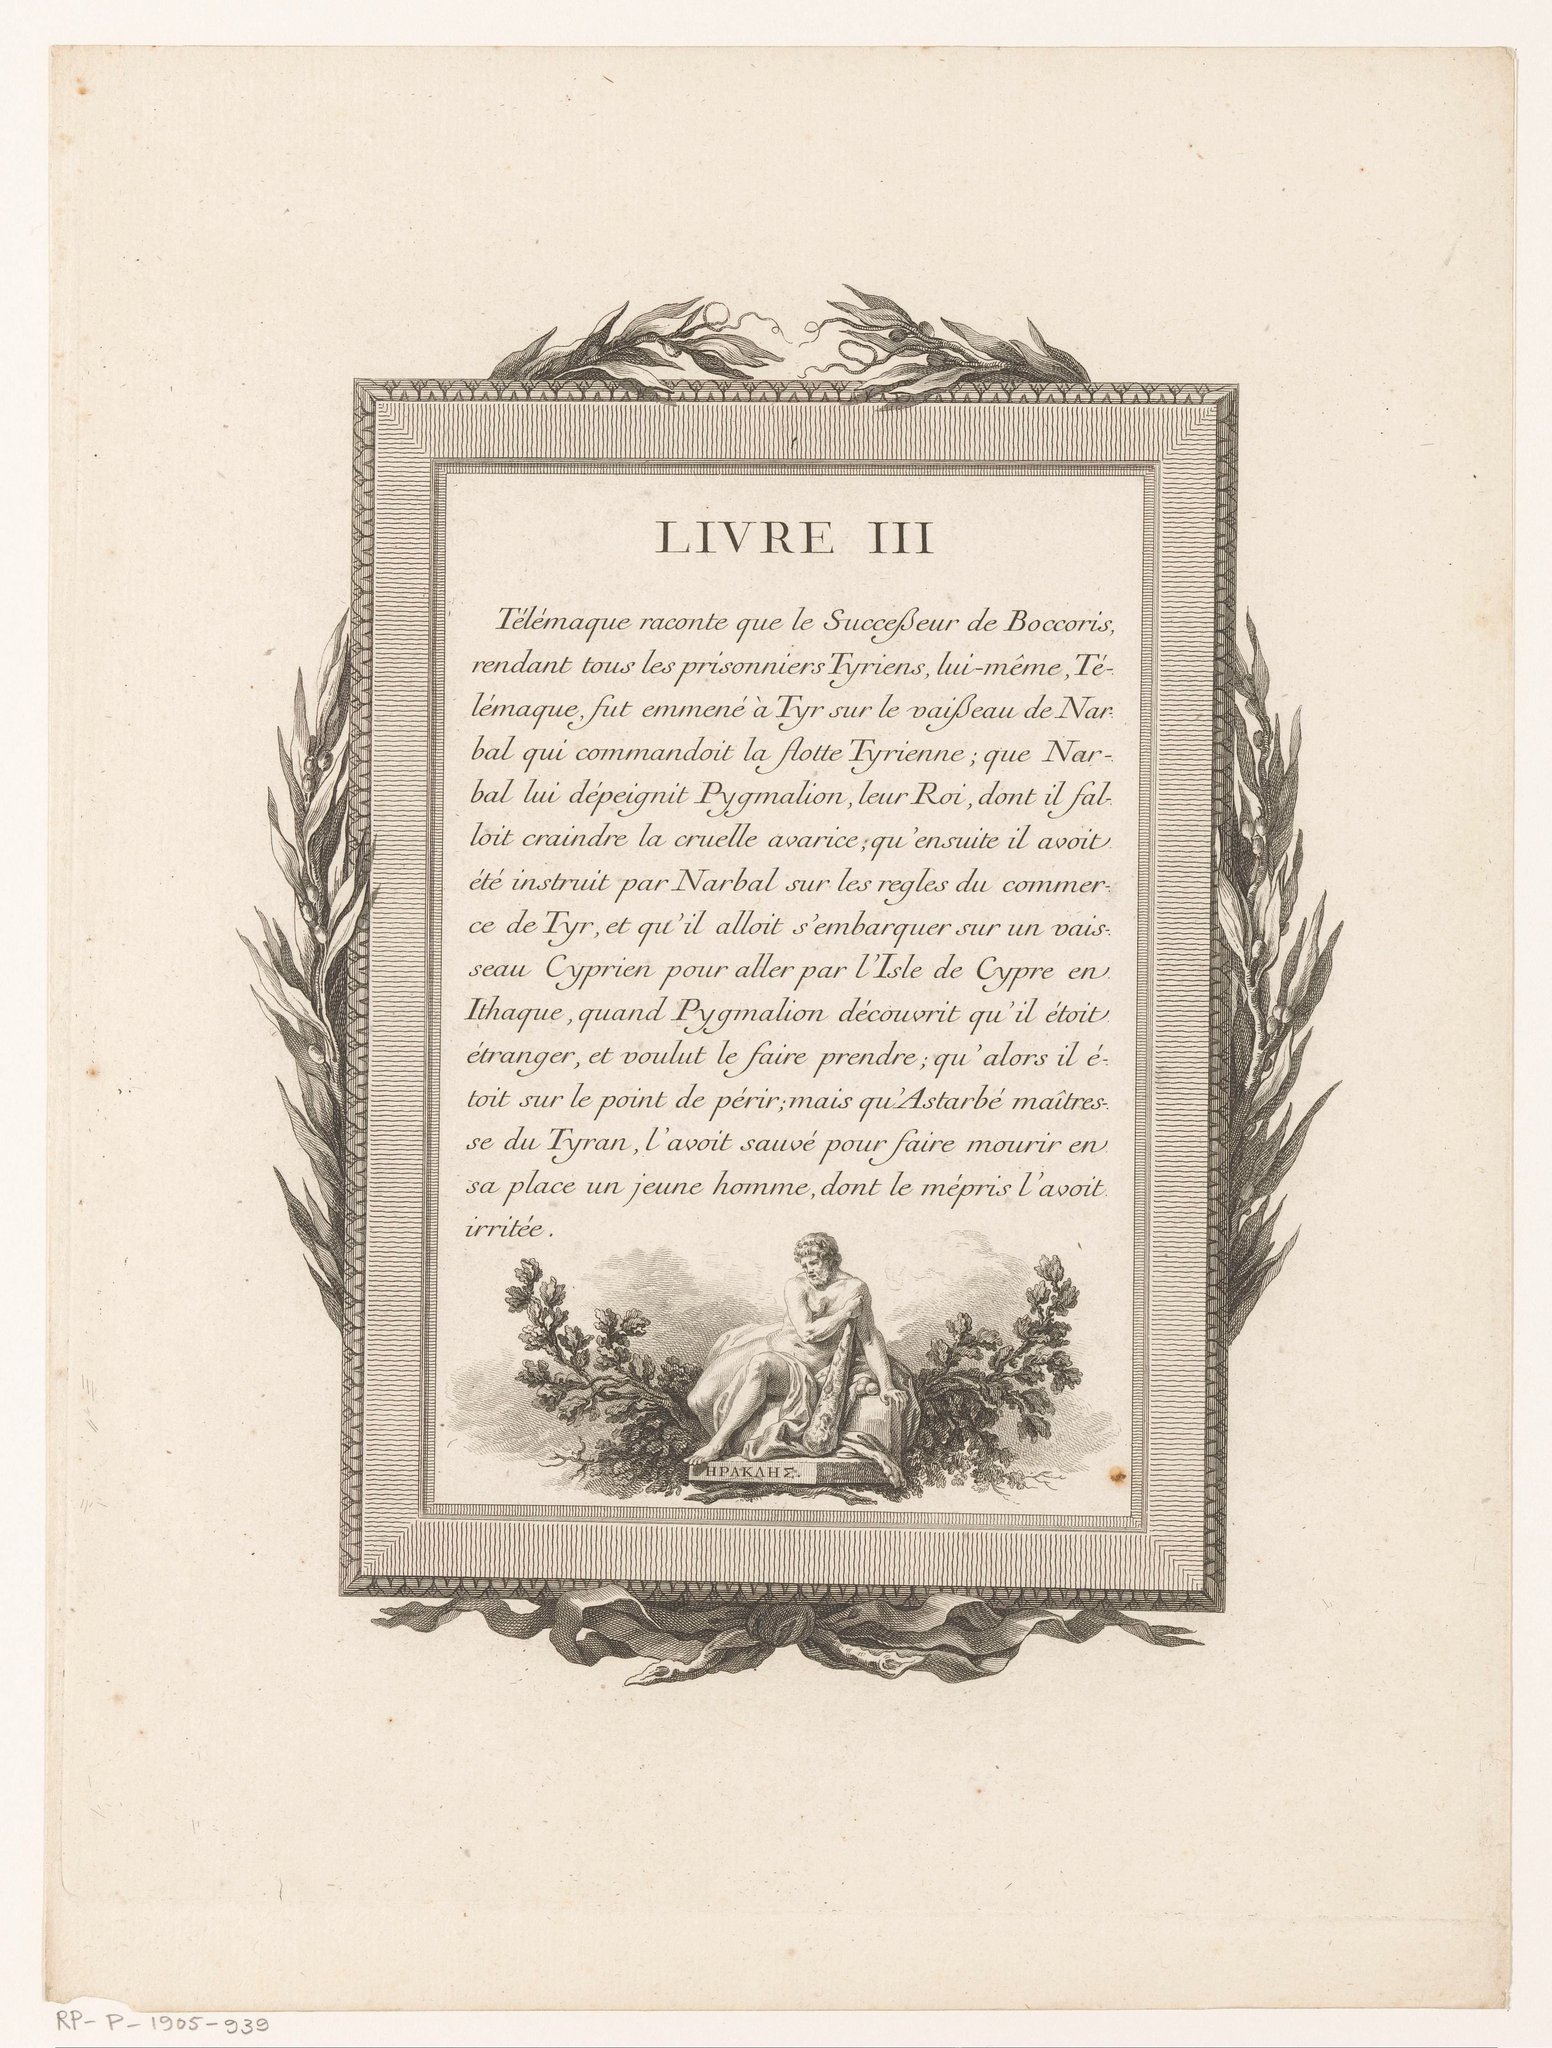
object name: book illustration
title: Omkaderde Franse tekst met Hercules en olijftakken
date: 1785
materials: paper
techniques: engraving, etching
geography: paris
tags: (story of) hercules (heracles), (fenelon, telemachus) specific works of literature (with author, title), ornament ~ festoon, garland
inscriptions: collector's mark: Lugt 2228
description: Vijftienregelige Franse tekst, getiteld 'Livre III' met daaronder een afbeelding van Hercules. De tekst wordt gekaderd door een sierlijst met olijftakken en onderaan een strik.